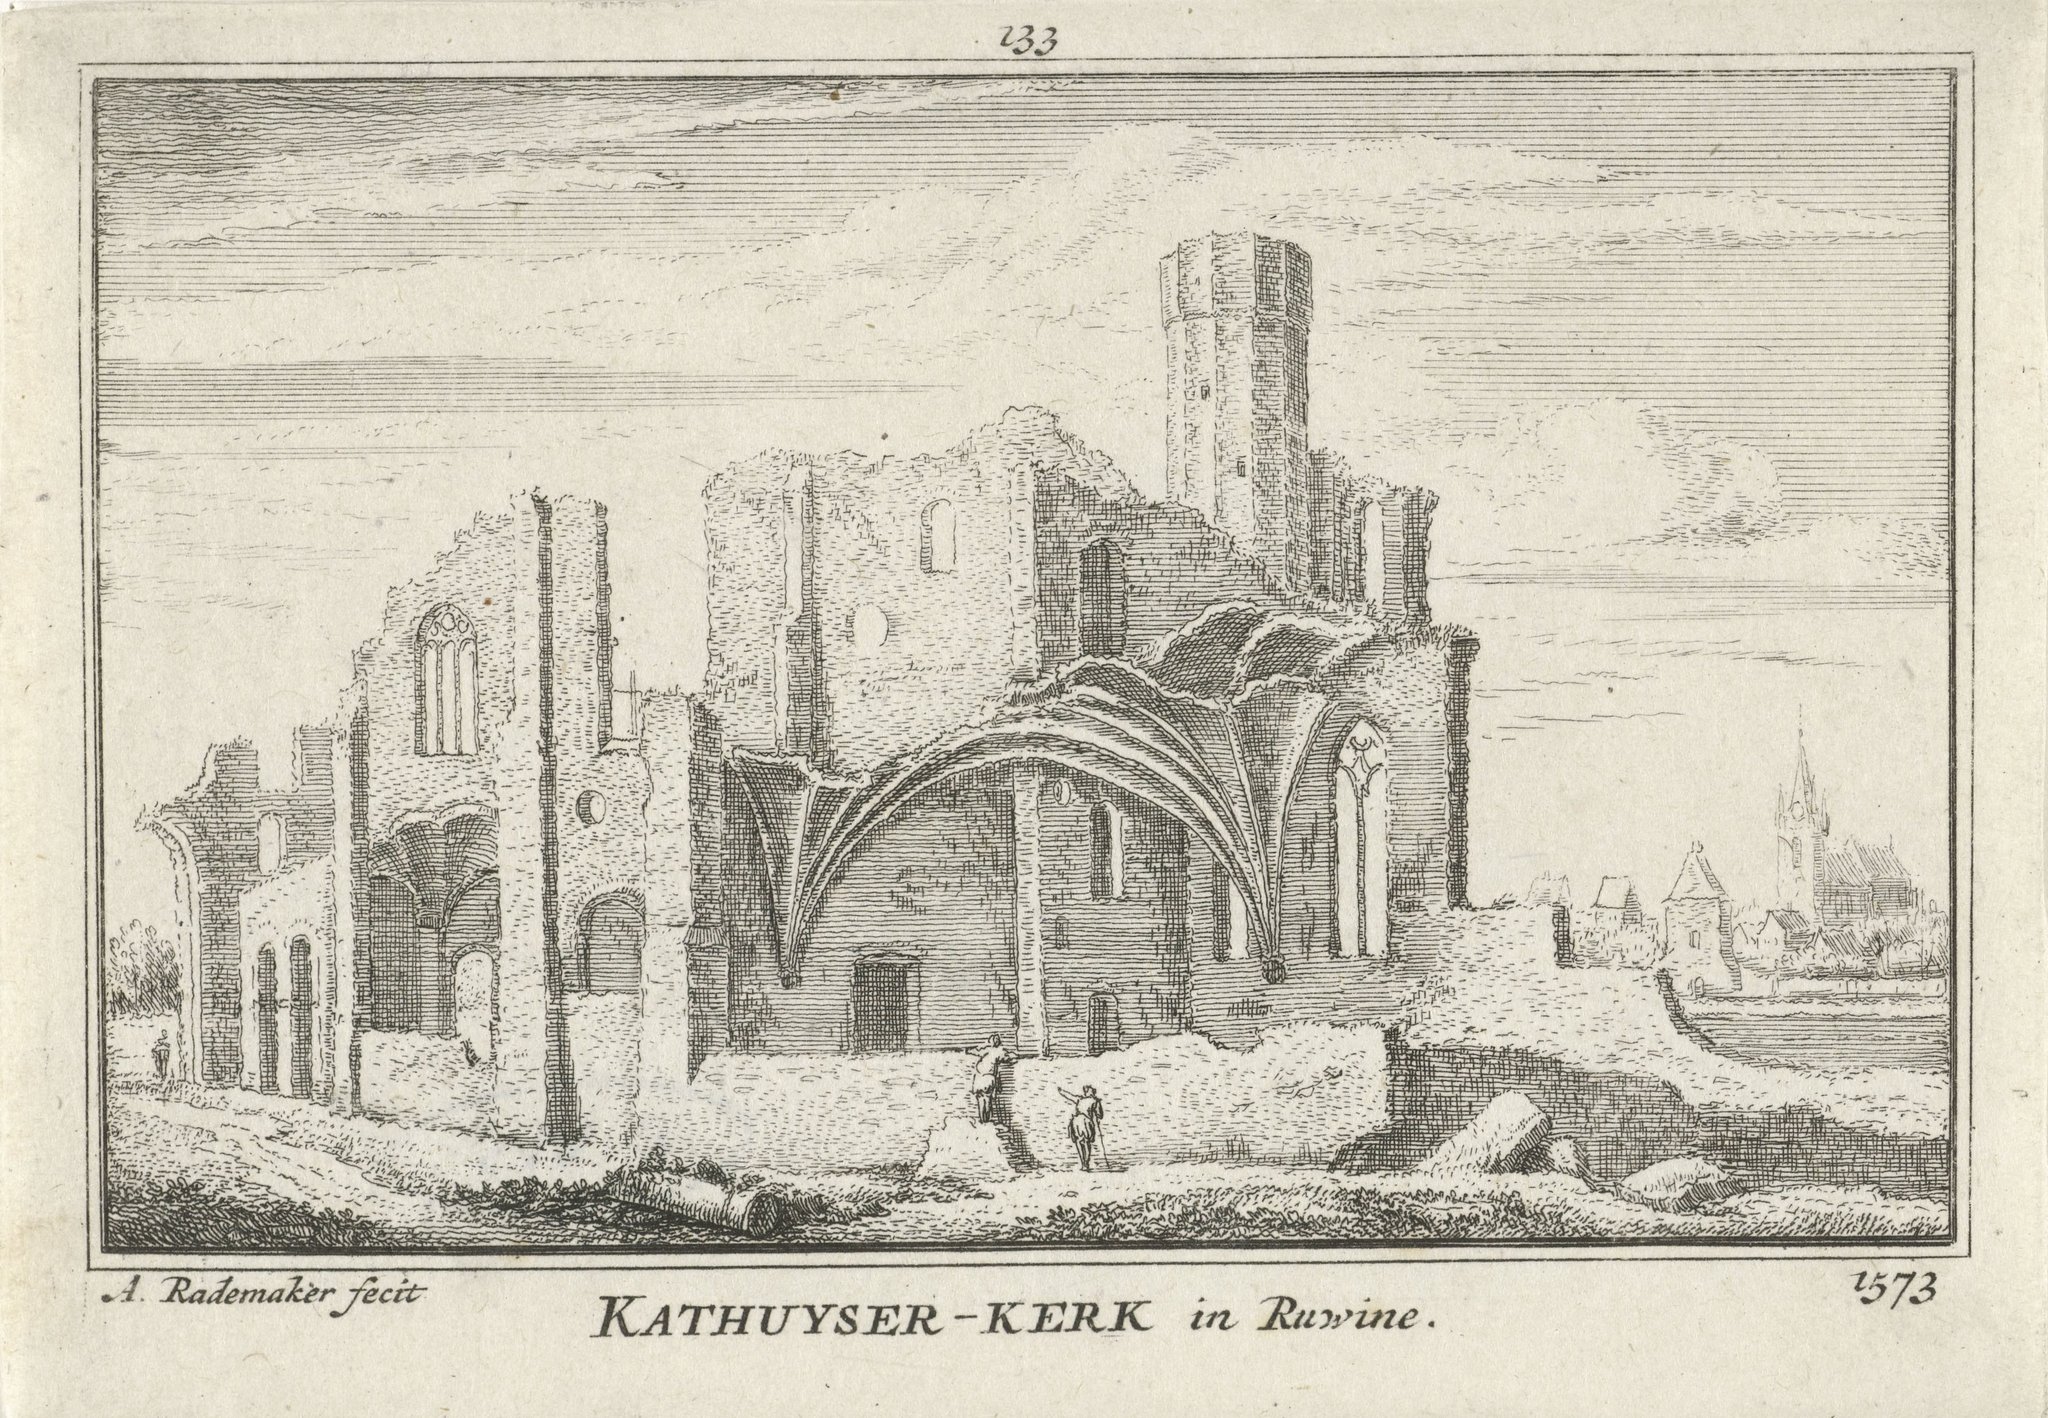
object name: print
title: Kathuyser-Kerk in ruwine 1573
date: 1727-1733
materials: paper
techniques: etching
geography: amsterdam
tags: ruin of church, monastery, etc., prospect of city, town panorama, silhouette of city, delft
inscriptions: collector's mark: Lugt 2228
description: Illustratie uit: Abraham Rademaker, Matthaeus Brouërius van Niedek, Isaac Le Long, Kabinet van Nederlandsche en Kleefsche outheden en (...) voorname stads- en landgebouwen, Willem Barents en Antoni Schoonenburg: Amsterdam, 1727-1733, ill. nr. 133.